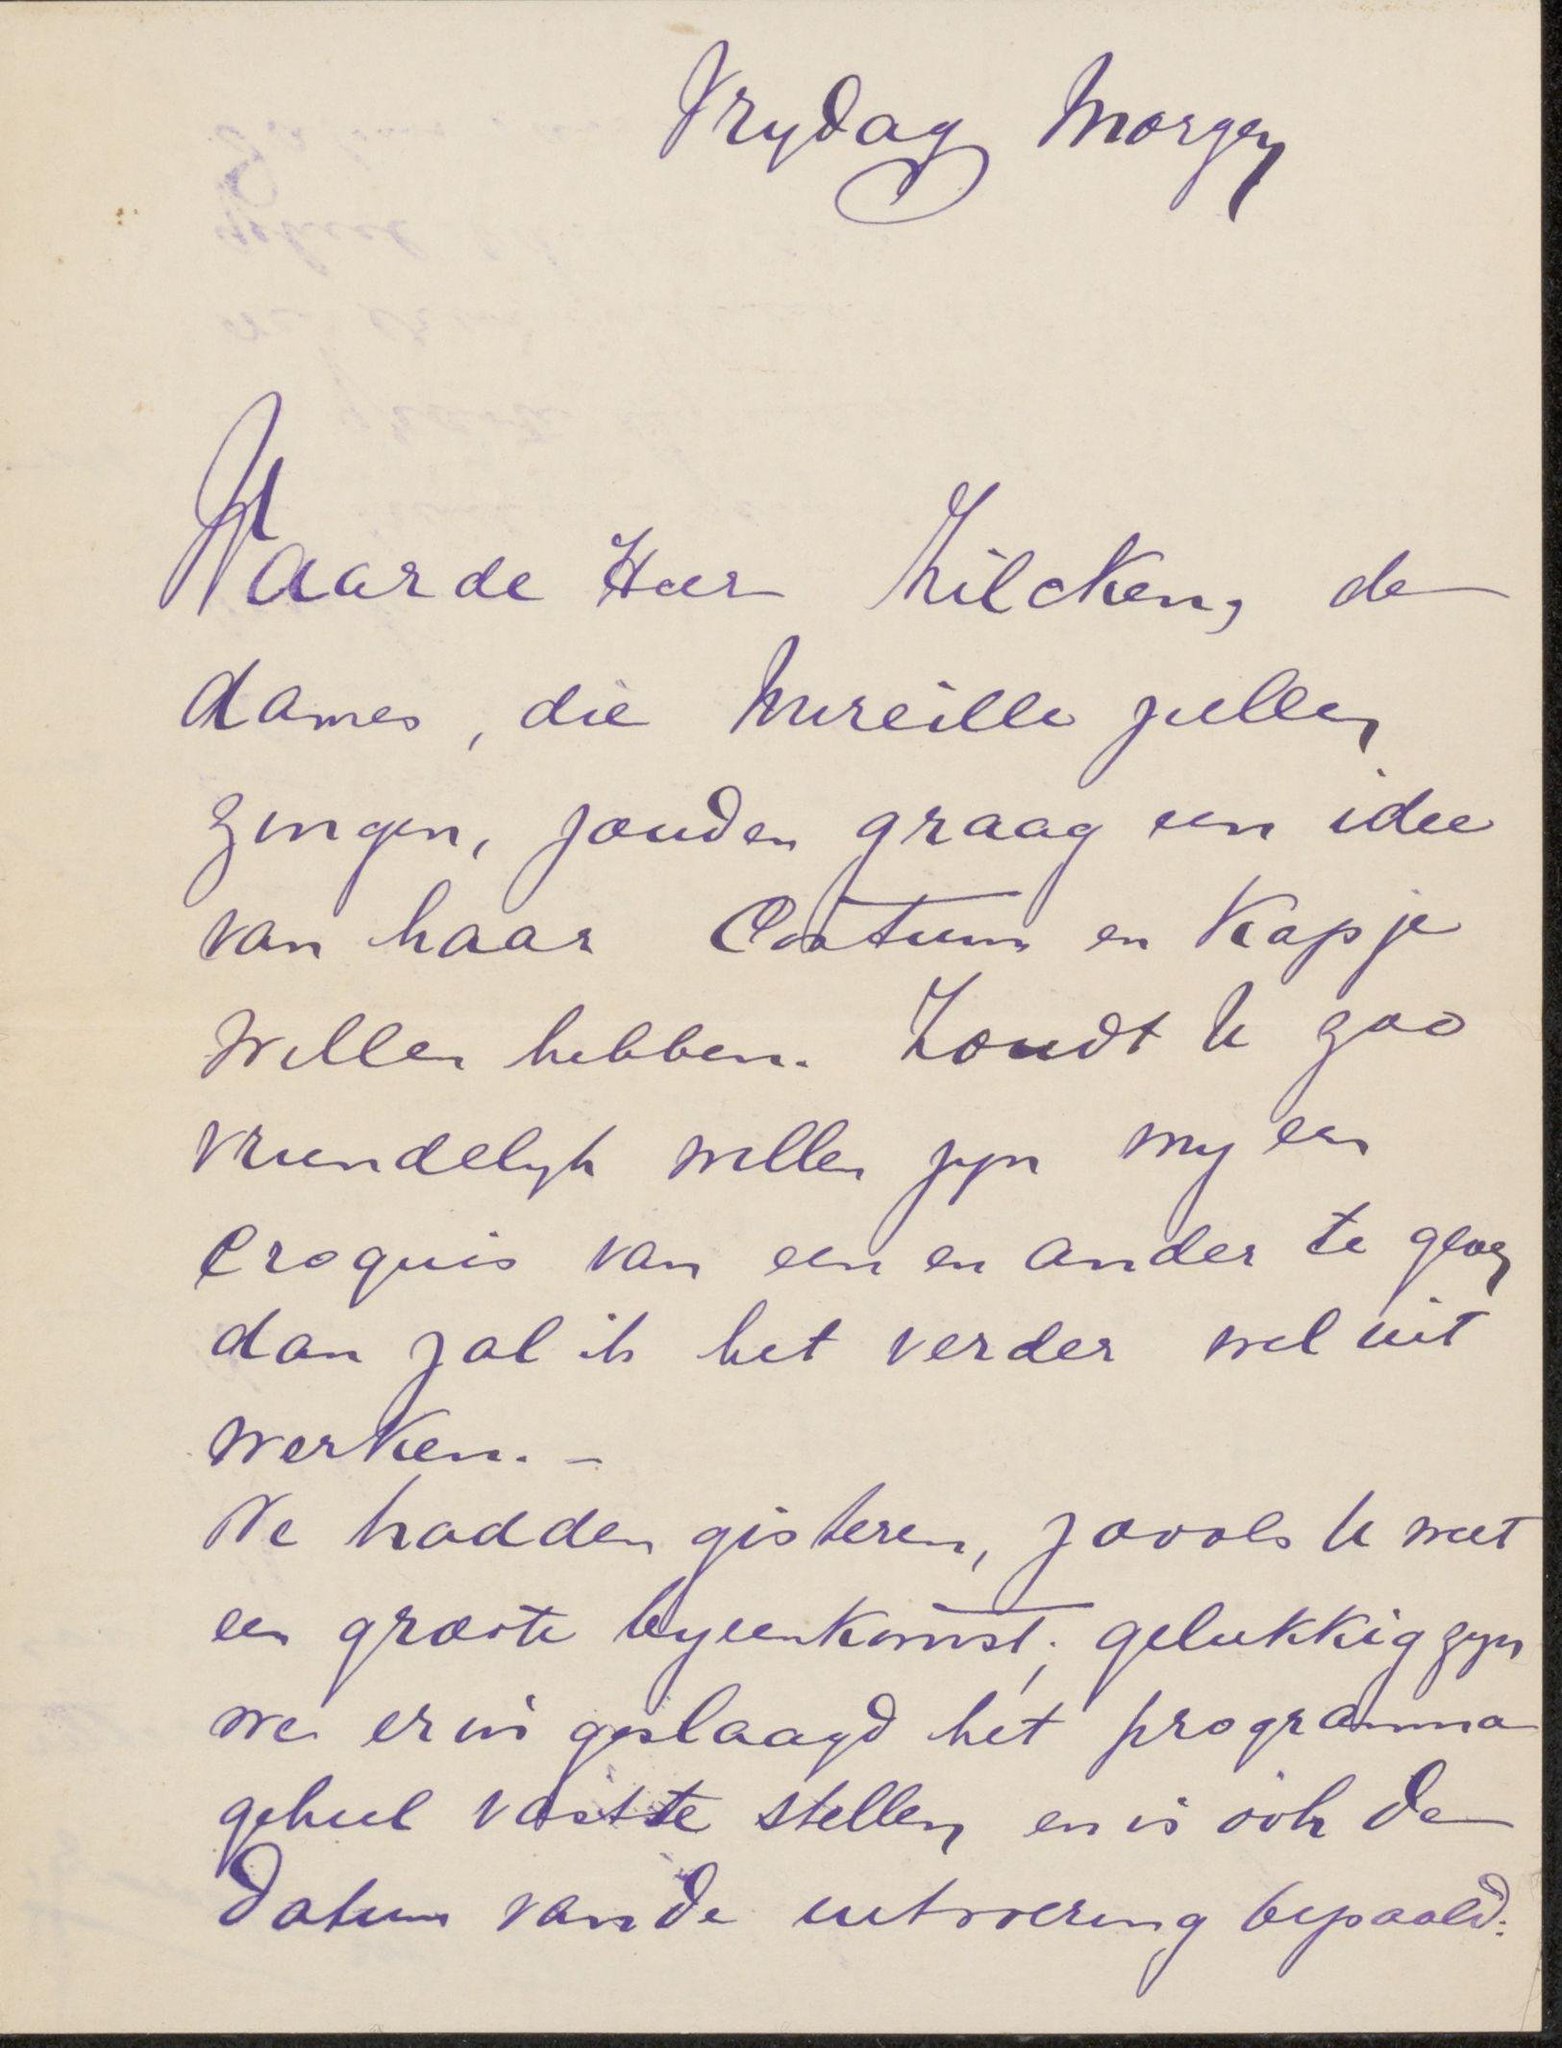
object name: letter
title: Brief aan Philip Zilcken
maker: carla van geuns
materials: ink, paper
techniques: pen, writing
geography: the hague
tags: painter, draughtsman, philip zilcken, the arts of the stage: ballet, theatre, musical drama, motion picture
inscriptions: collector's mark: ‘RPK’